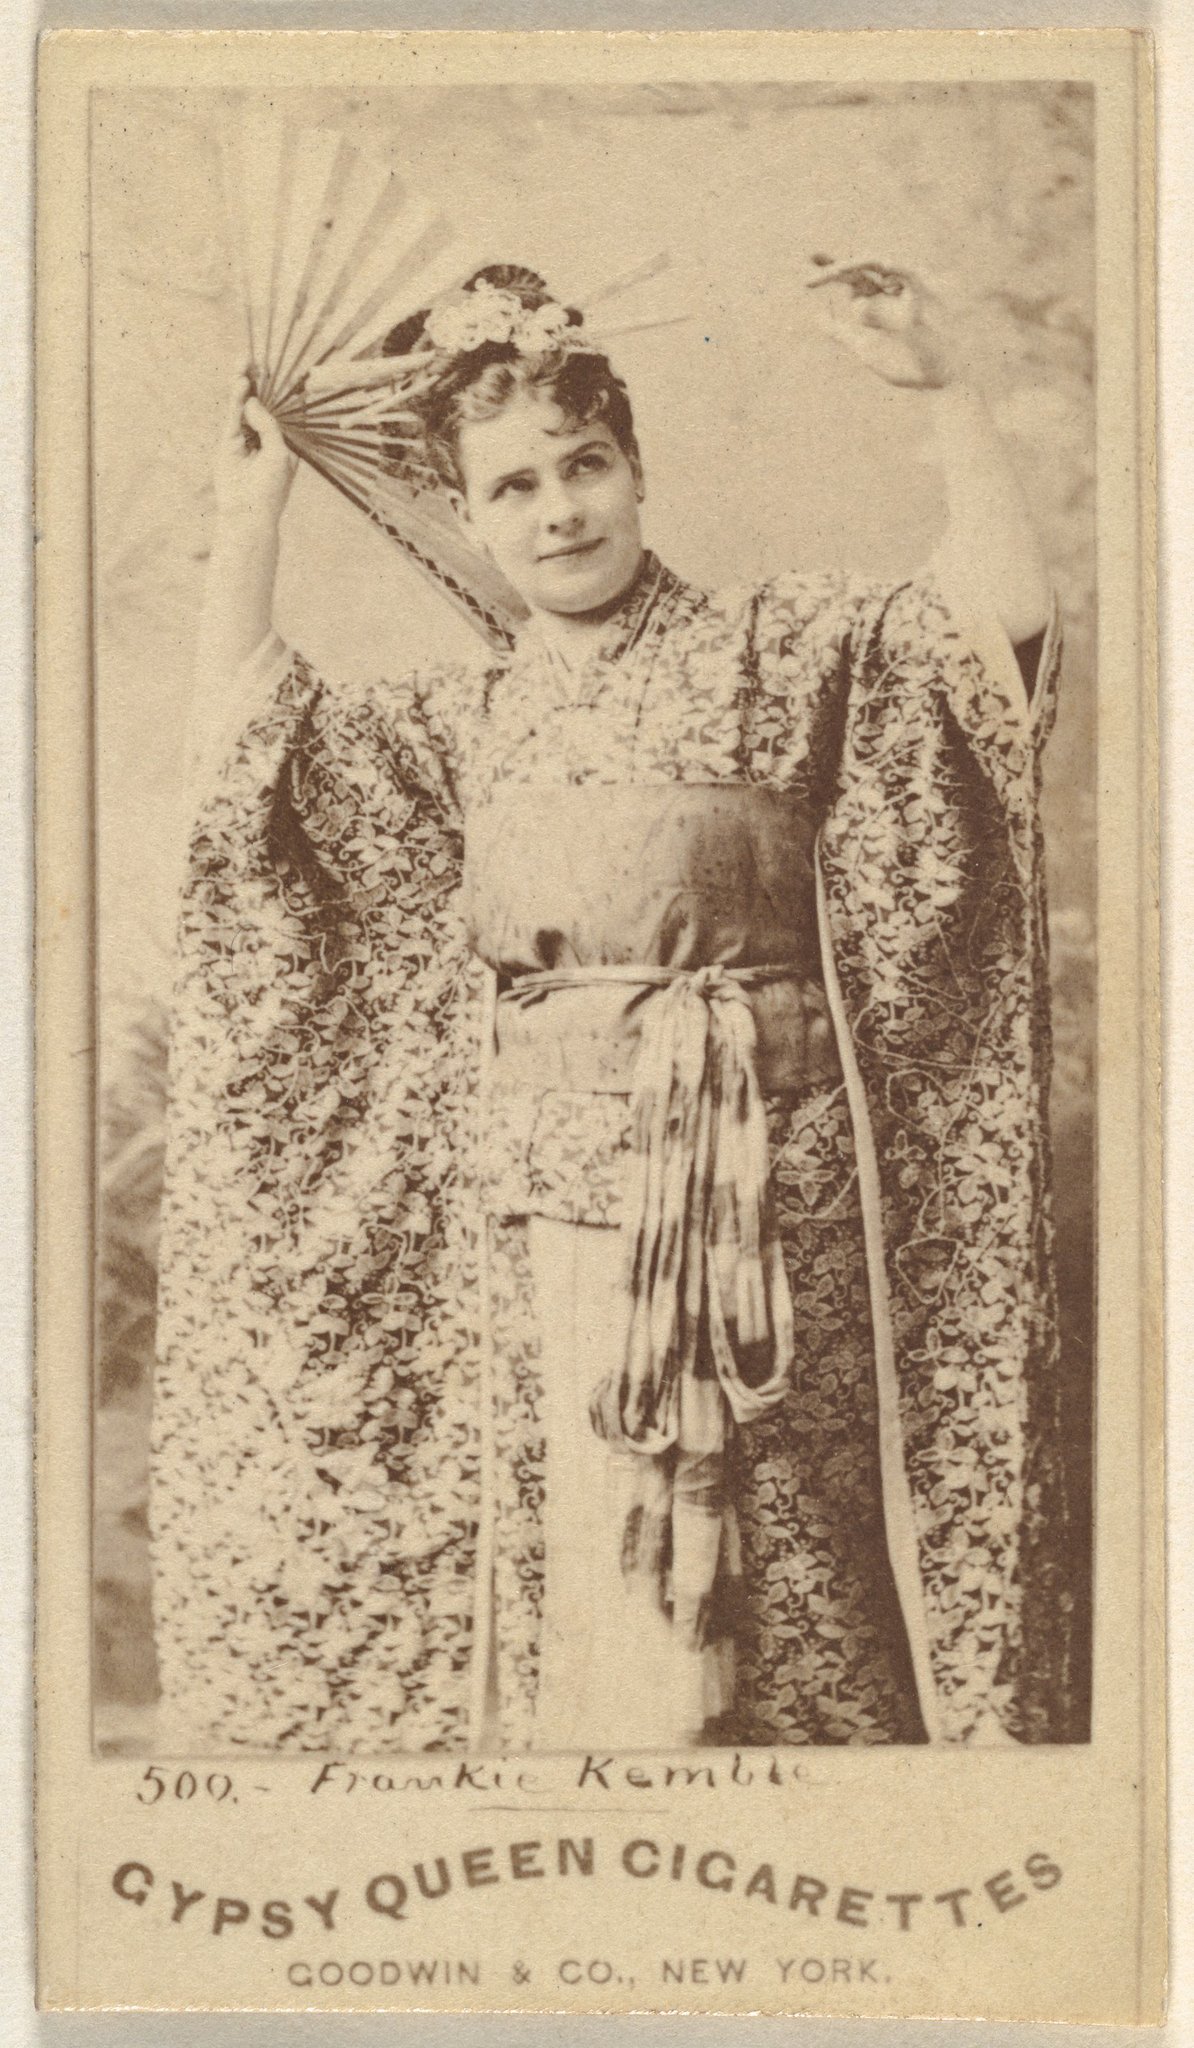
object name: photograph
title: Frankie Kemble, from the Actors and Actresses series (N171) for Gypsy Queen Cigarettes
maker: goodwin & company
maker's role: publisher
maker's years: 1850-1950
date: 1886-1890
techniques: albumen silver print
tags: portraits,women,actresses